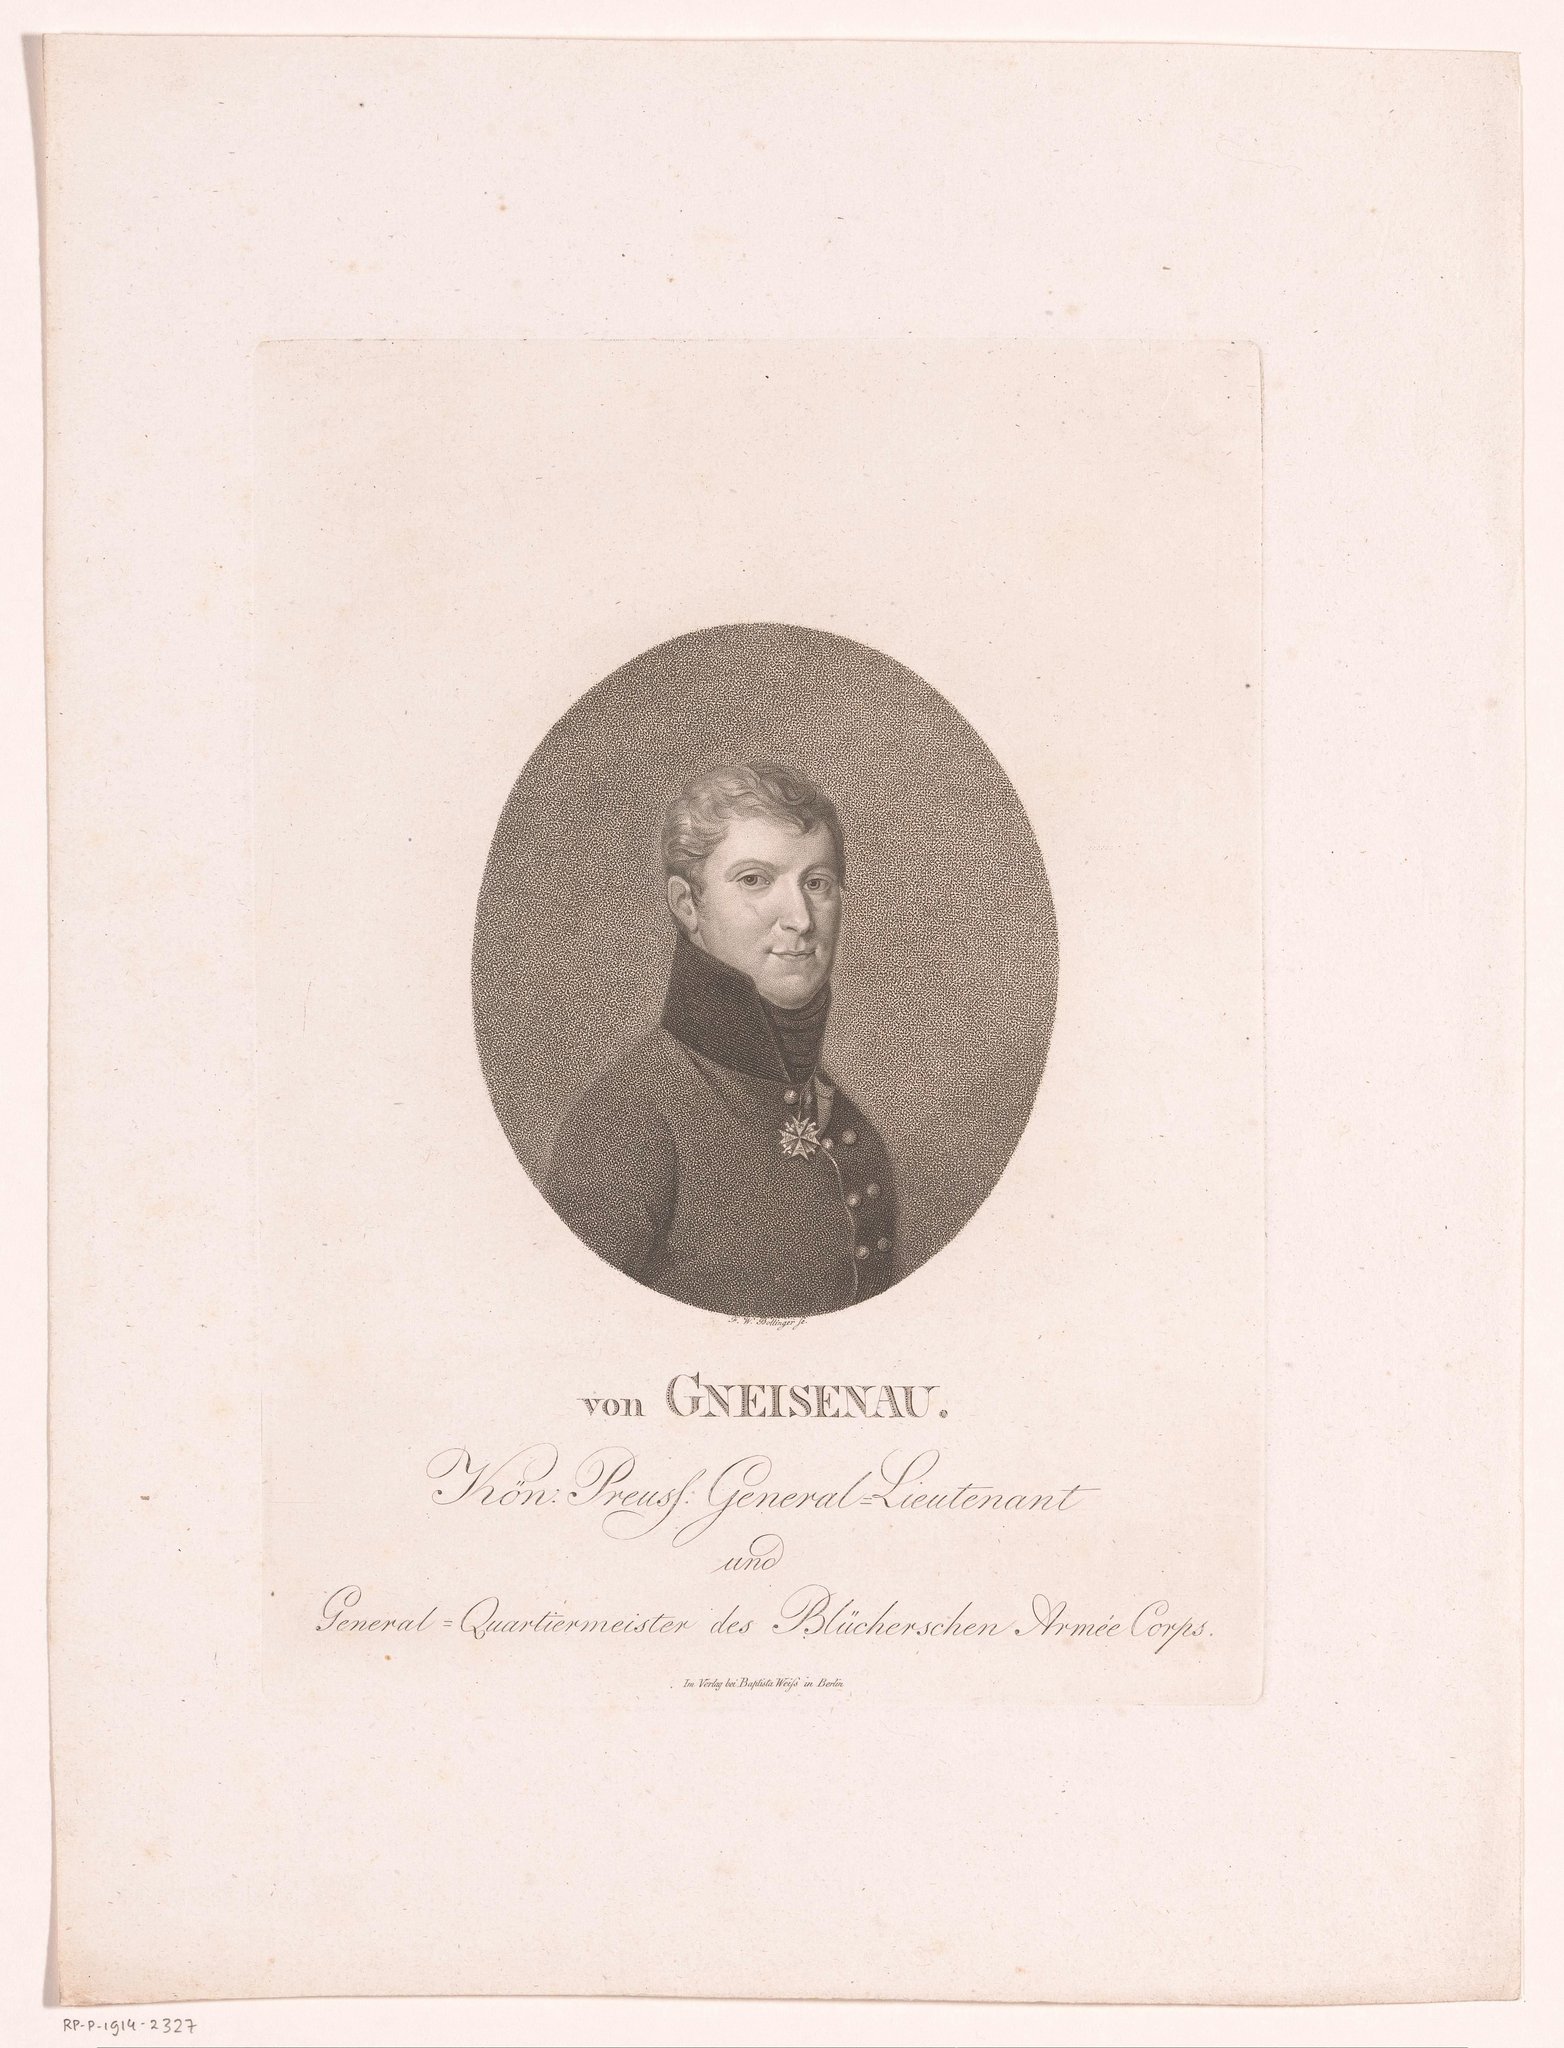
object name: print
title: Portret van August Wilhelm Antonius Neidhardt von Gneisenau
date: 1813-1825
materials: paper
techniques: stippling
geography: berlin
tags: knighthood order, historical persons, (military) uniforms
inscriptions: collector's mark: Lugt 2228